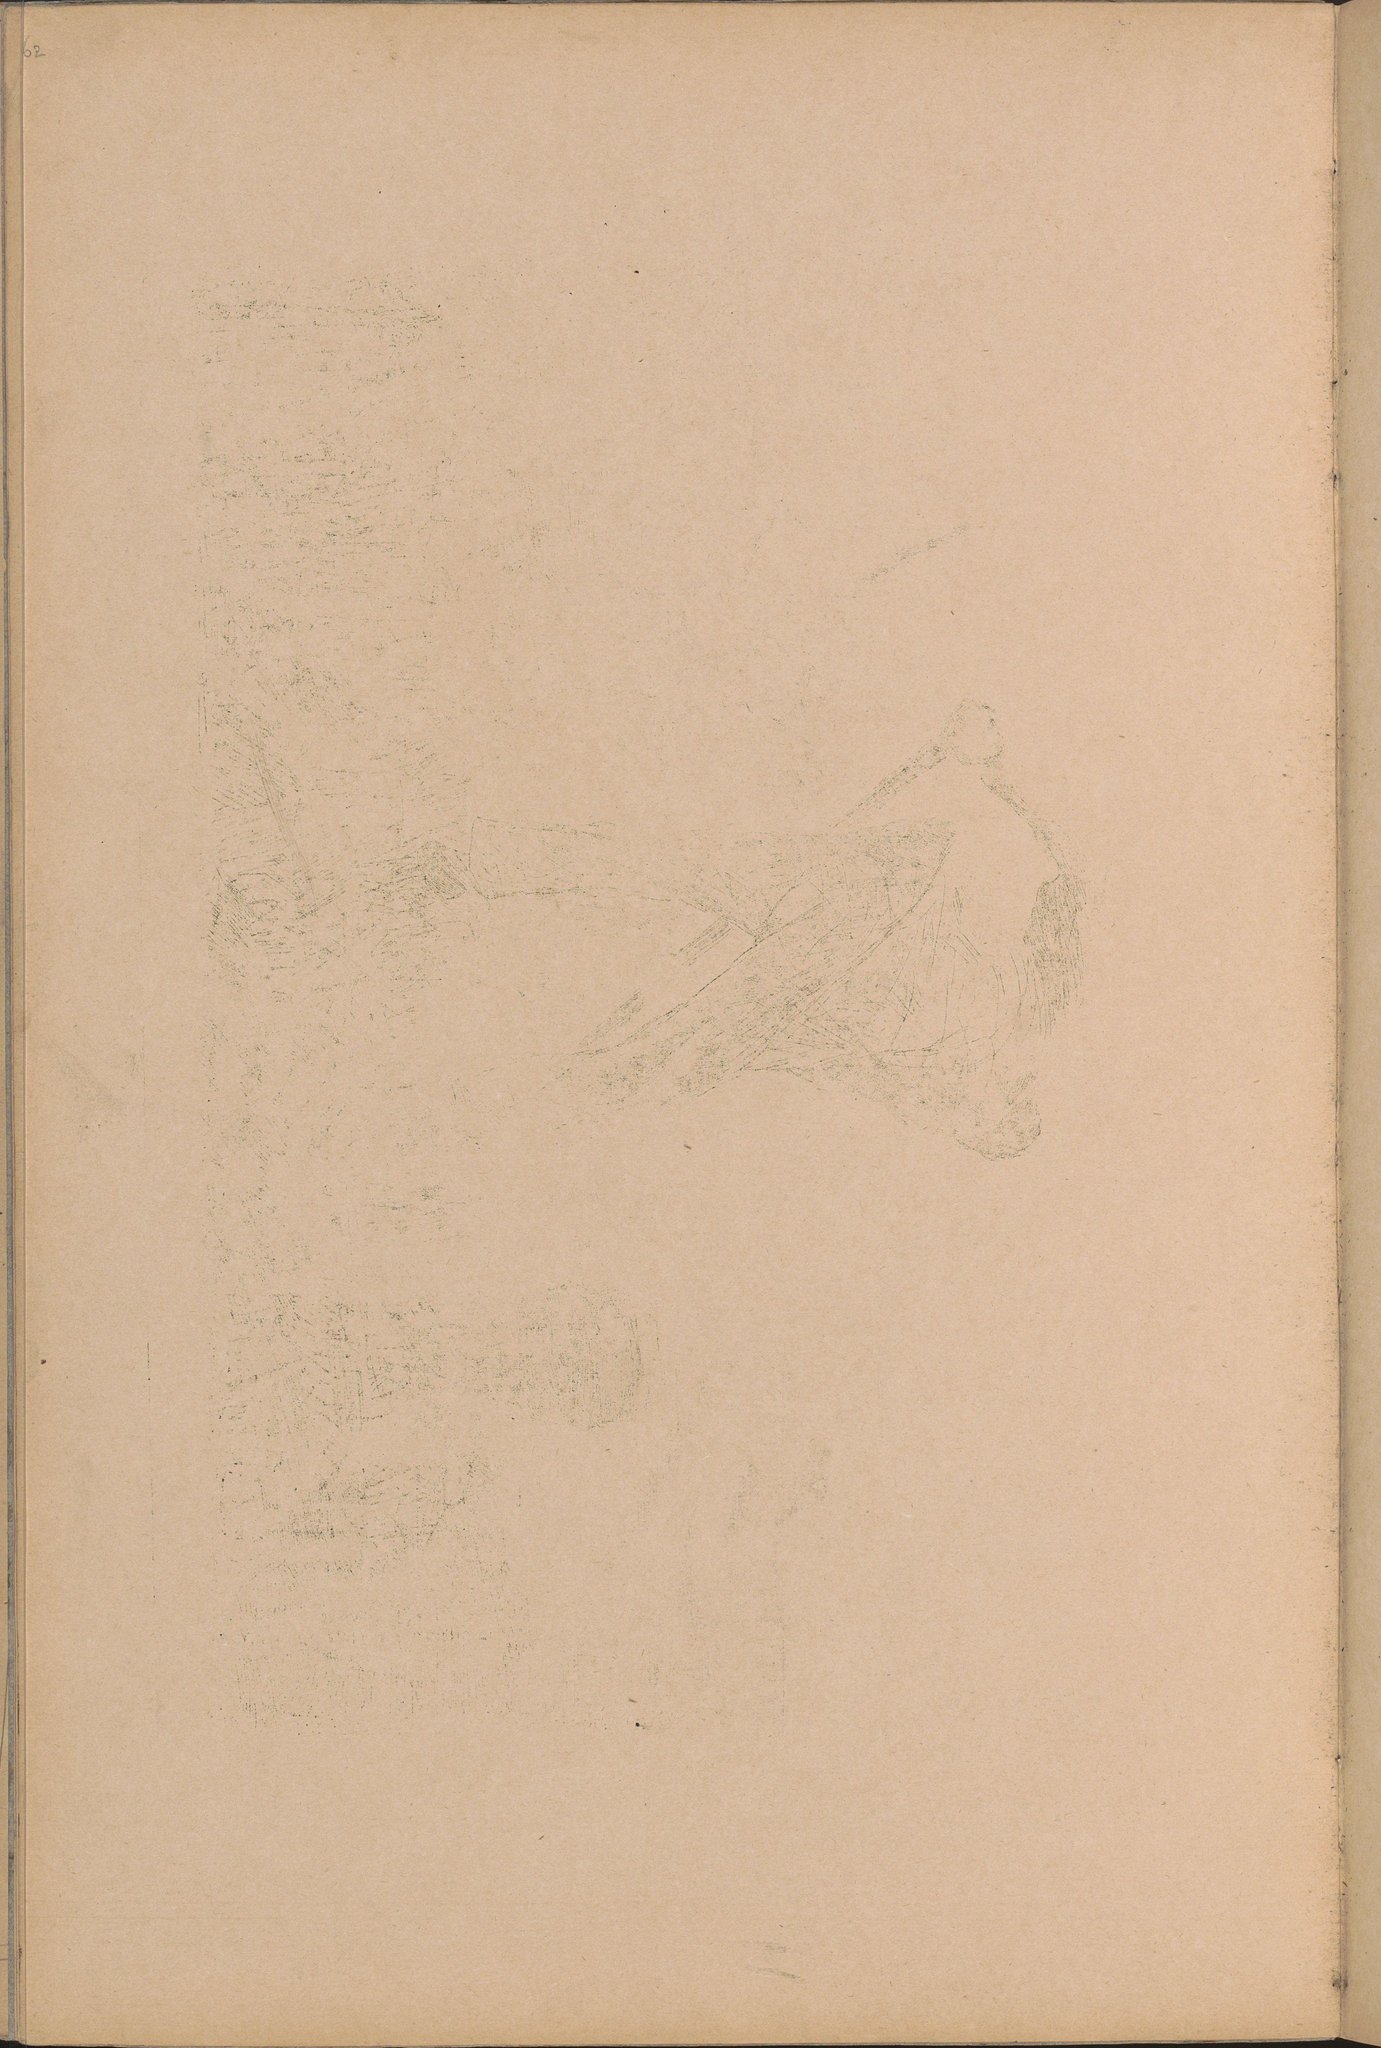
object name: sketchbook leaf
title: Abklatsch van een tekening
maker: willem witsen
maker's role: draughtsman, painter, print maker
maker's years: 1860-1923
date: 1884-1887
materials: paper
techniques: printmaking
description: De tekening van een gravende man is niet meer aanwezig. Pagina 62 uit een schetsboek met 44 bladen.